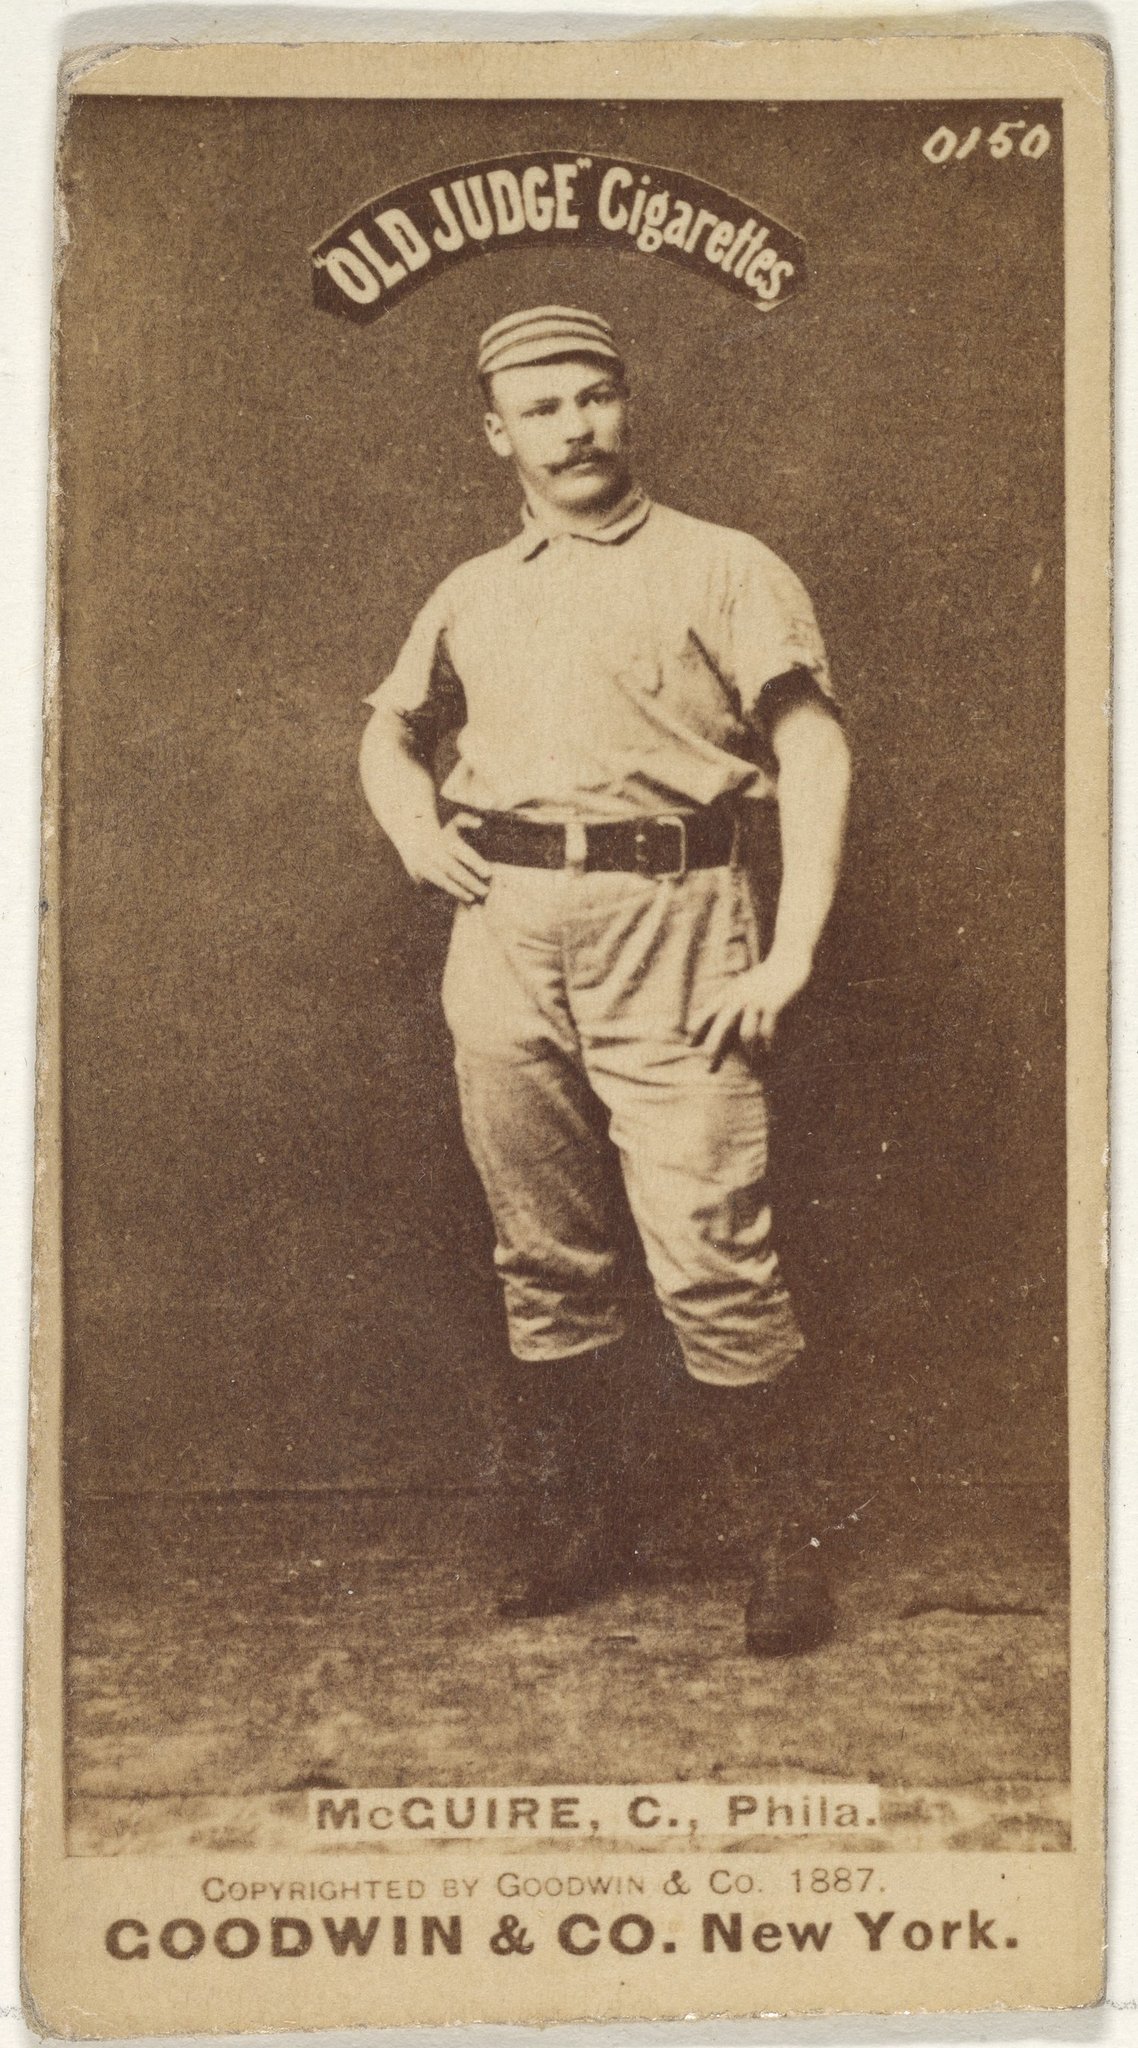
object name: baseball card, photograph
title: James Thomas "Deacon" McGuire, Catcher, Philadelphia, from the Old Judge series (N172) for Old Judge Cigarettes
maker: goodwin & company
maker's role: publisher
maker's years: 1850-1950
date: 1887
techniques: albumen silver print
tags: men,portraits,baseball,athletes